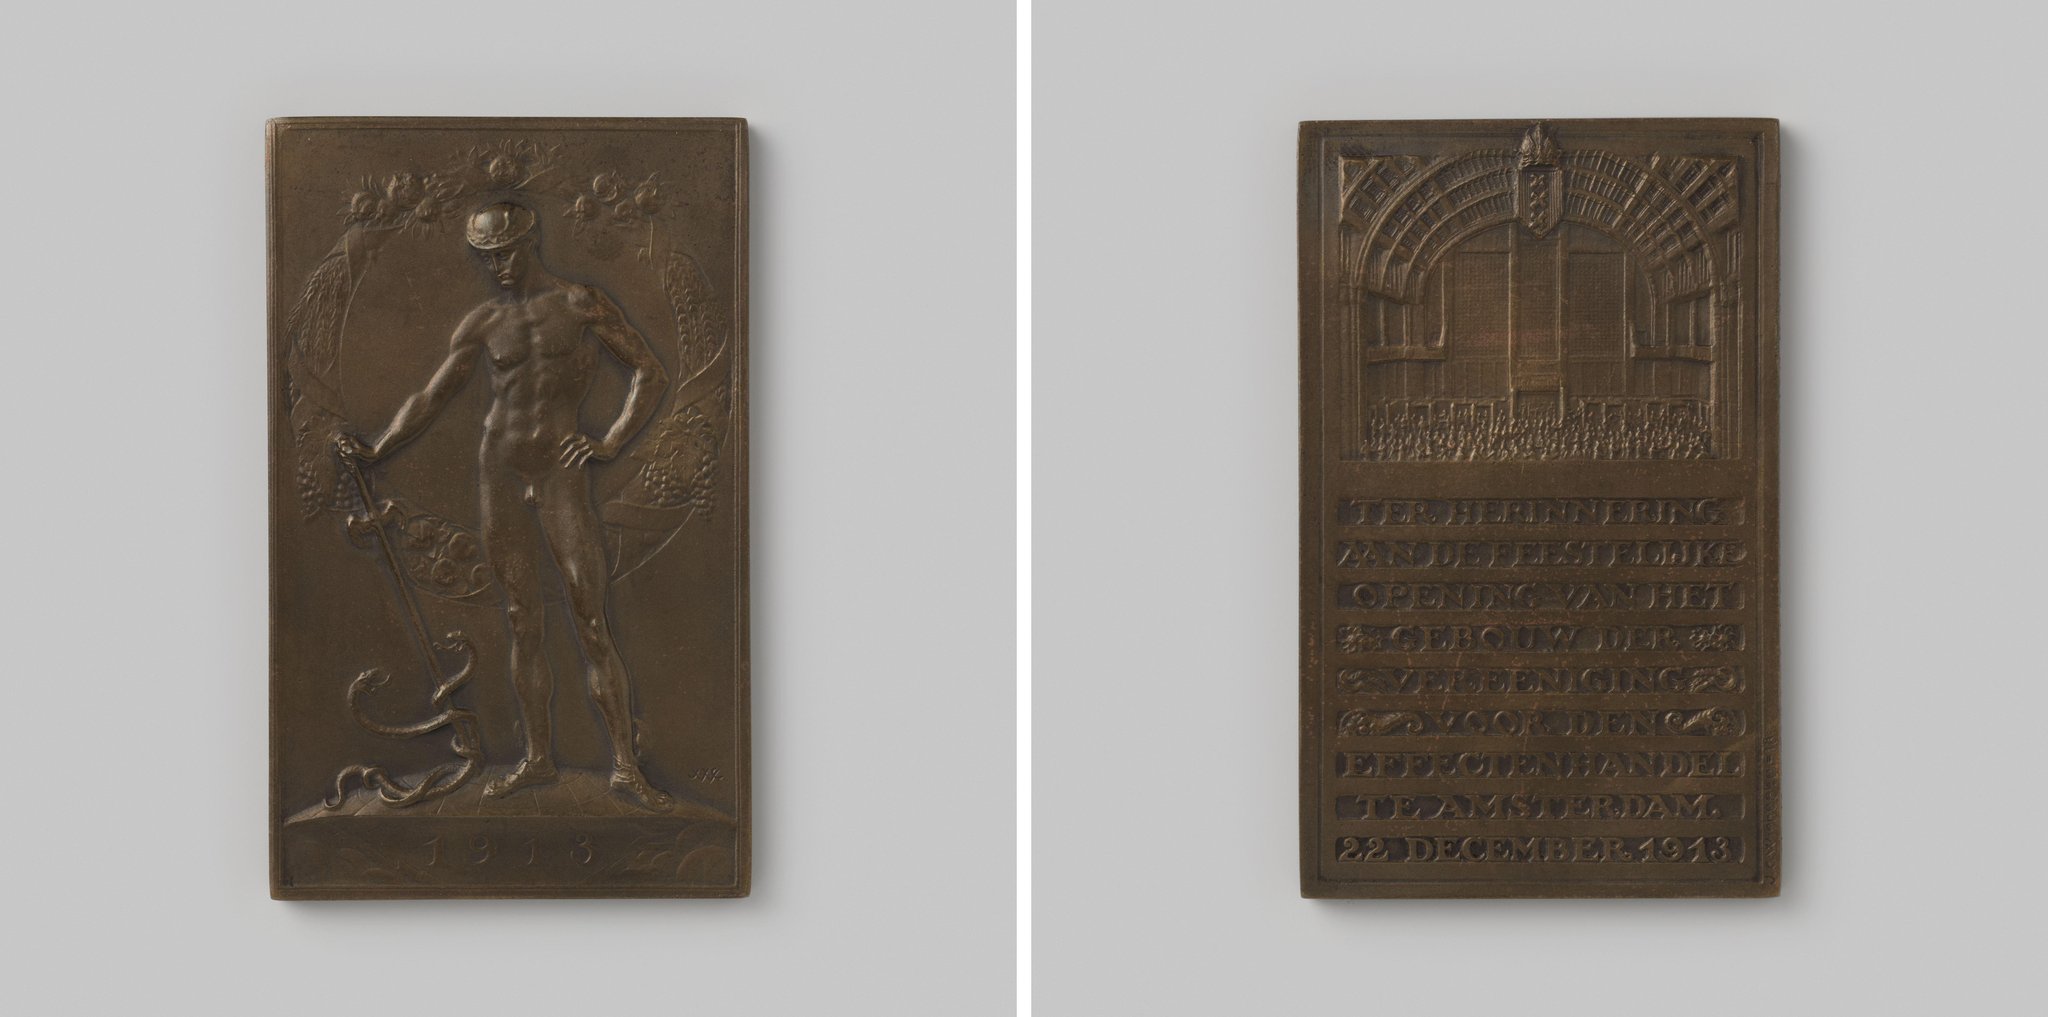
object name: history medal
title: Opening van het gebouw van de Vereeniging voor den Effectenhandel te Amsterdam 1913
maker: johannes cornelis wienecke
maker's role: medailleur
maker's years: 1872-1945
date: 1913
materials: bronze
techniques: striking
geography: utrecht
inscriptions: inscription: ‘L. R. GRATAMA, LID DER FIRMA JAN KALFF & C°’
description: Rechthoekige bronzen plaquette, op de voorzijde Mercurius staand met staf, op de achtergrond een krans, het jaartal in afsnede, op de keerzijde afgebeeld het interieur van het gebouw waaronder negen regels tekst op verdiepte regels, met randinscriptie.